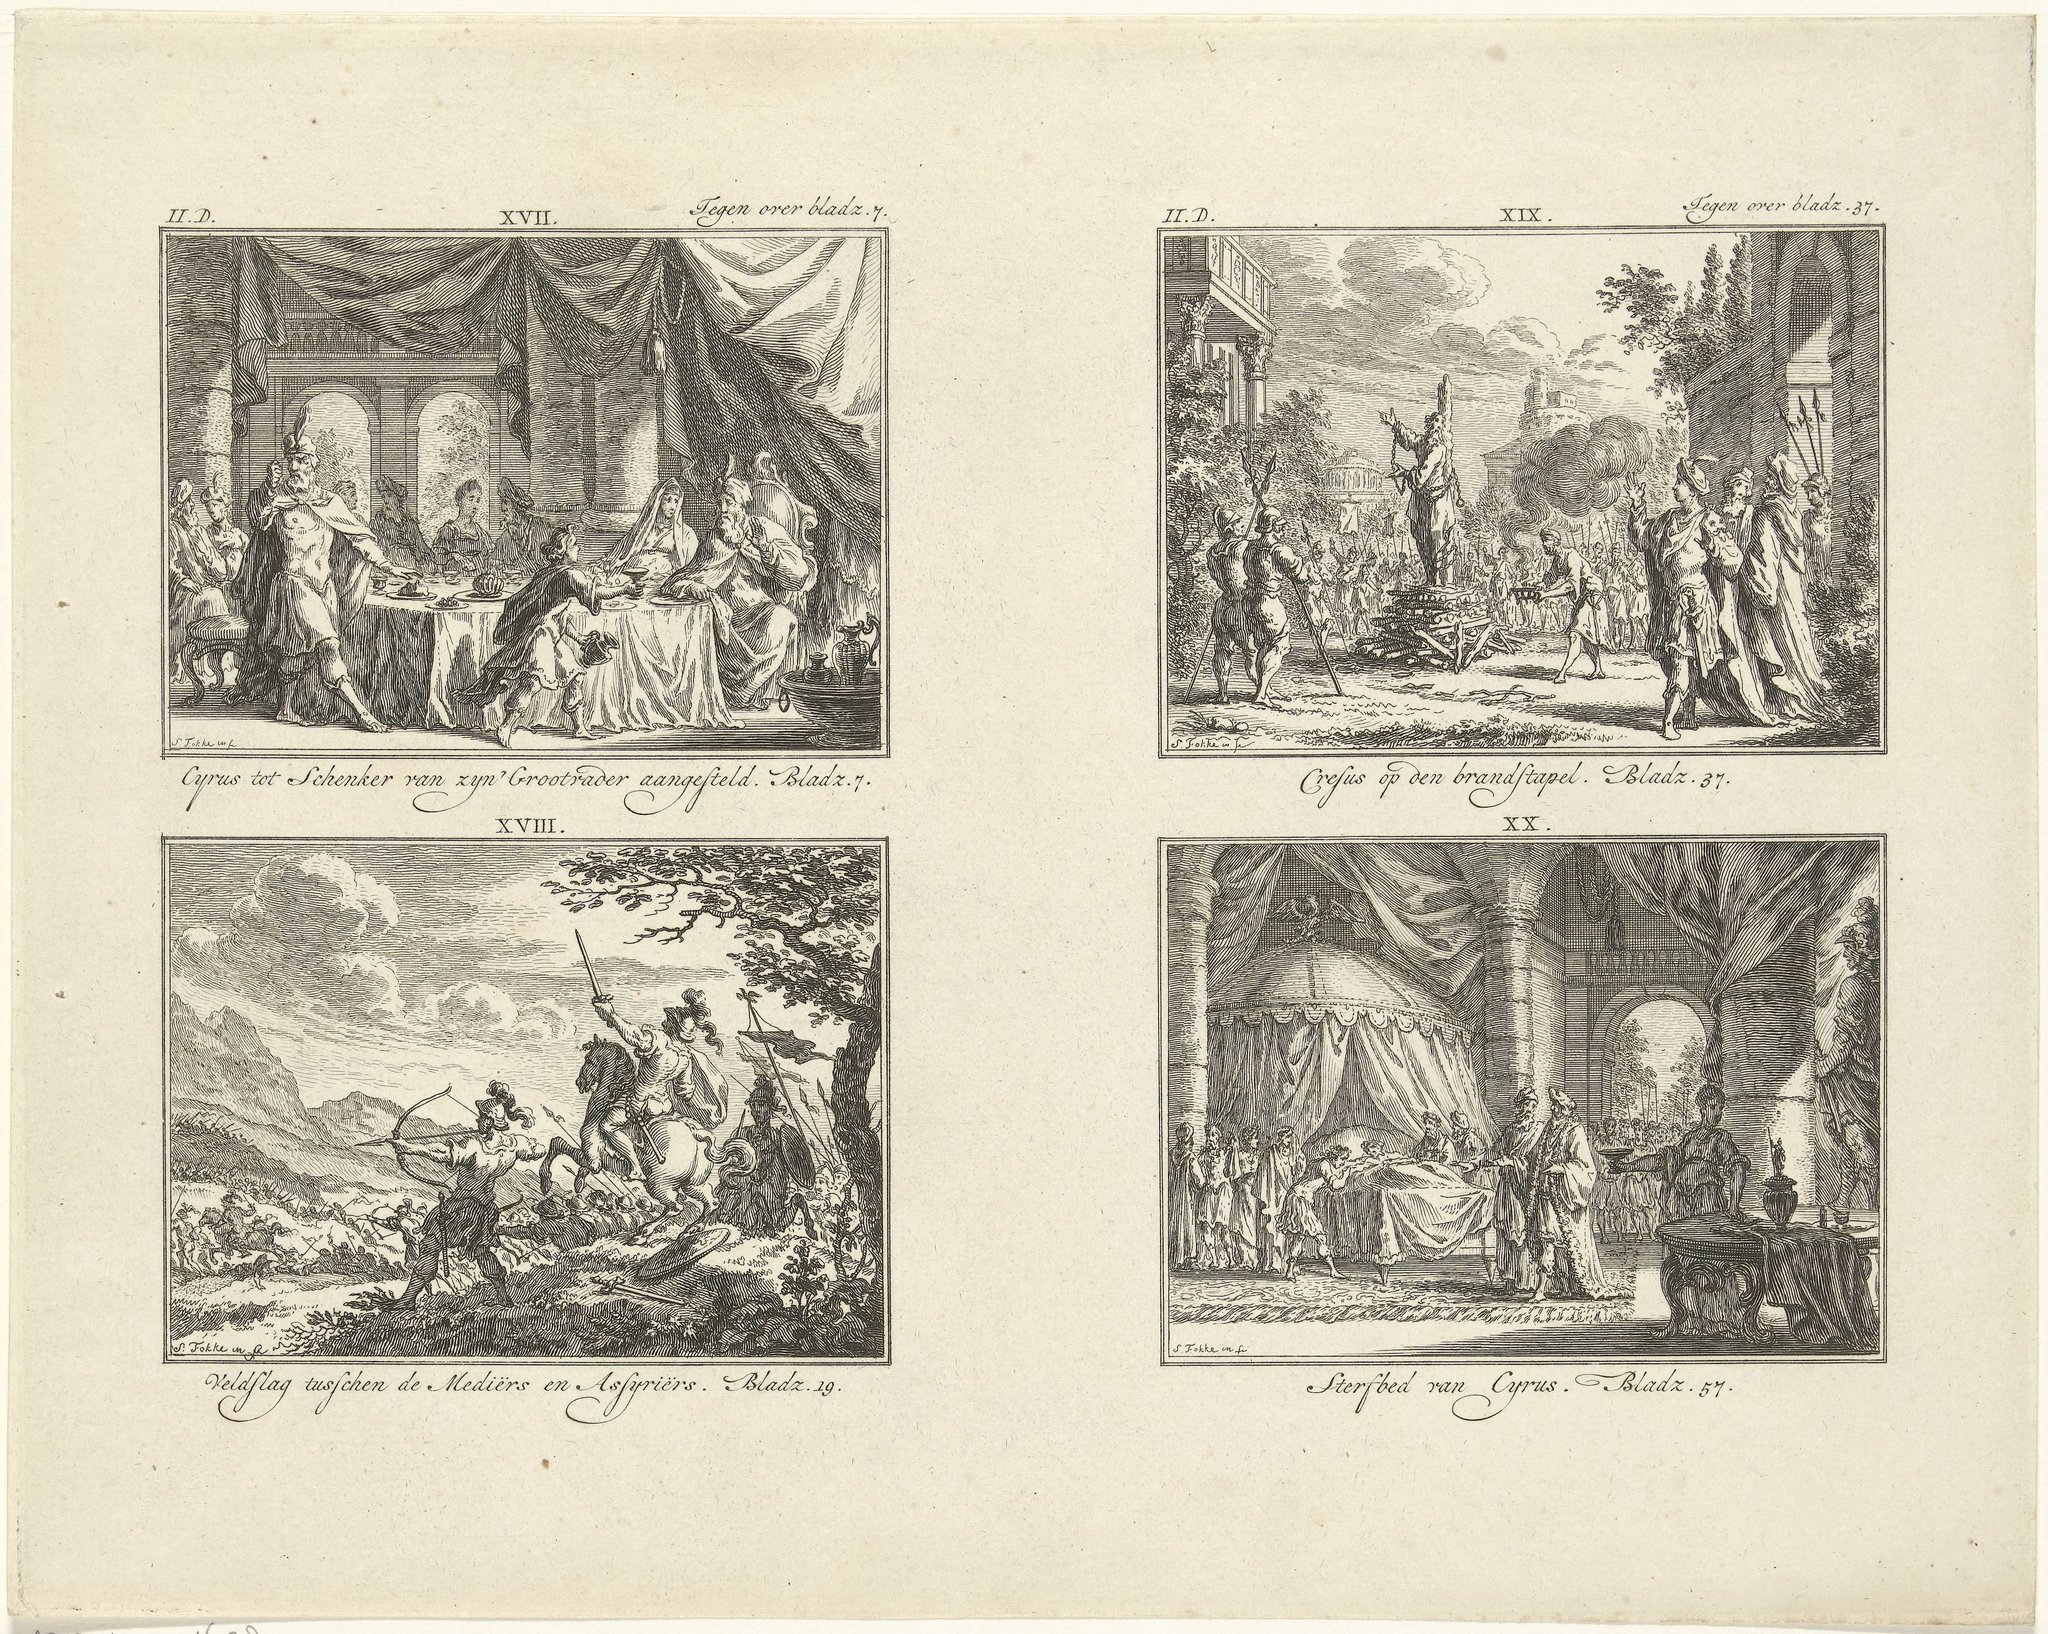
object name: print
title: Vier voorstellingen uit de klassieke geschiedenis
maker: simon fokke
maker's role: draughtsman, print maker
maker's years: 1712-1784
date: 1722-1784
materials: paper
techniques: etching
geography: amsterdam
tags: battle, (story of) c. furius cressinus, (story of) cyrus king of persia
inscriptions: collector's mark: Lugt 2228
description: Vier voorstellingen uit de klassieke geschiedenis van één plaat, genummerd van XVII tot en met XX en alle voorzien van een onderschrift. Linksboven: Cyrus tot schenker van zijn grootvader aangesteld. Linksonder: Veldslag tussen de Mediërs en de Assyriërs. Rechtsboven: Cresus op de brandstapel. Rechtsonder: Sterfbed van Cyrus. Voorstellingen XVII en XVIII rechtsboven gemerkt: Tegen over bladz. 7. Voorstellingen XIX en XX rechtsboven gemerkt: Tegen over bladz. 37.